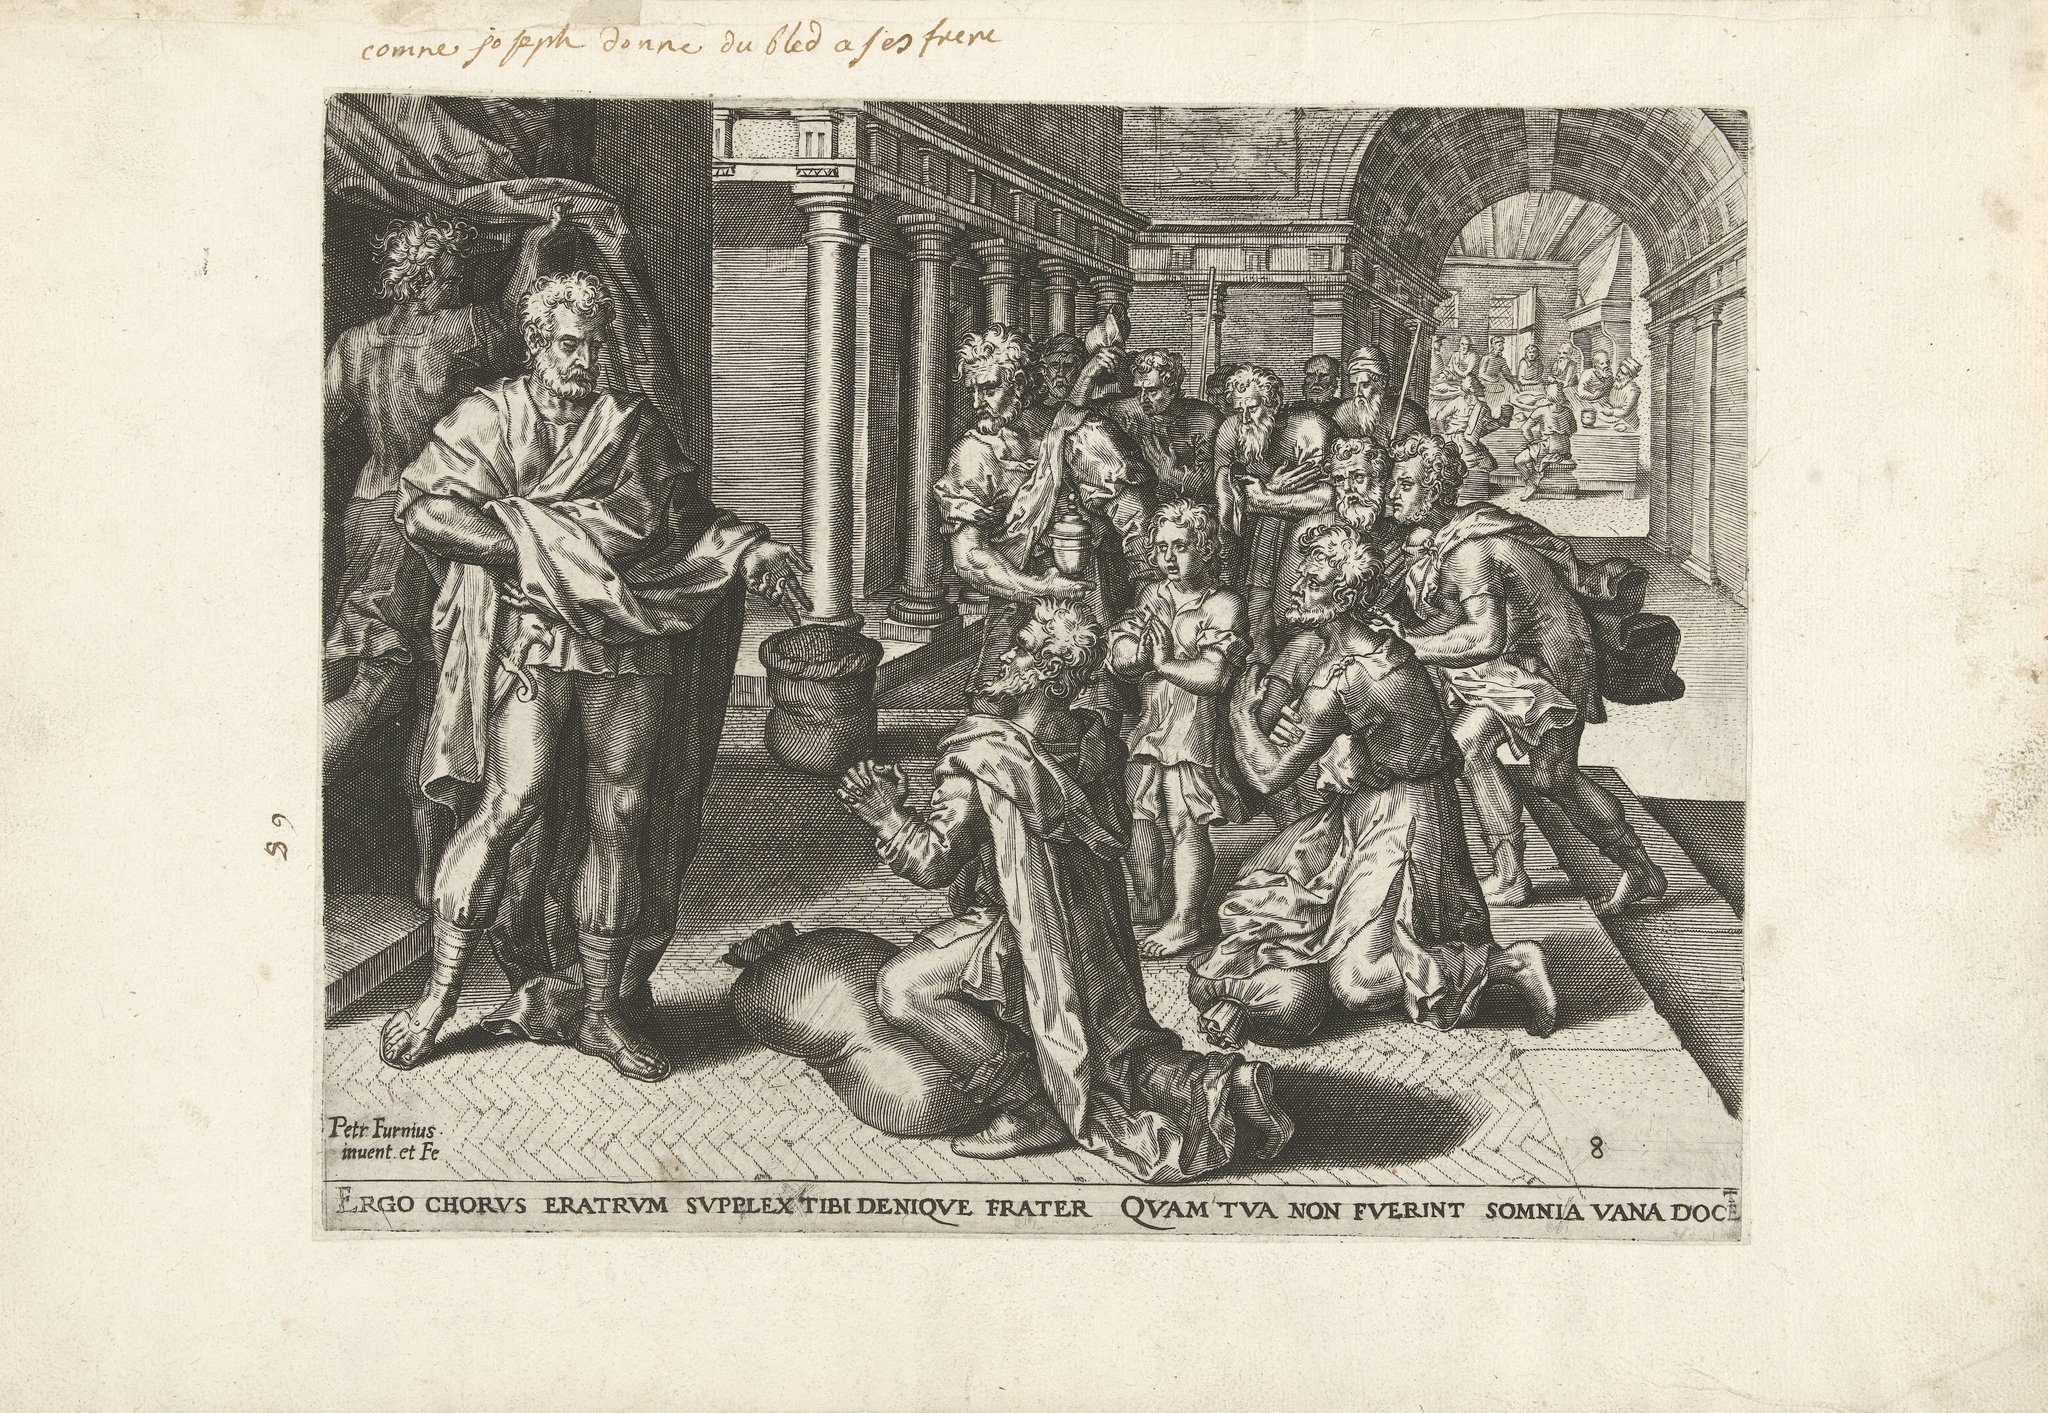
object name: print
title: Geschiedenis van Jozef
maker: pieter jalhea furnius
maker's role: print maker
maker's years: 1540-1626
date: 1572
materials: paper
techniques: engraving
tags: the brothers before joseph: judah pleads for benjamin and offers to be retained as a slave in his stead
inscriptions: collector's mark: Lugt 2228, number: ‘68’, inscription: ‘comme joseph donne du bled a ses freres’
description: De broers van Jozef zitten geknield voor hem. Ze smeken Jozef om Benjamin niet in Egypte achter te laten. De jonge Benjamin staat met gevouwen handen tussen zijn broers. Op de achtergrond het verzoeningsmaal. Onder de voorstelling staat een regel tekst in het Latijn, rechtsonder genummerd: 8. De prent maakt deel uit van een serie prenten over het leven van Jozef.